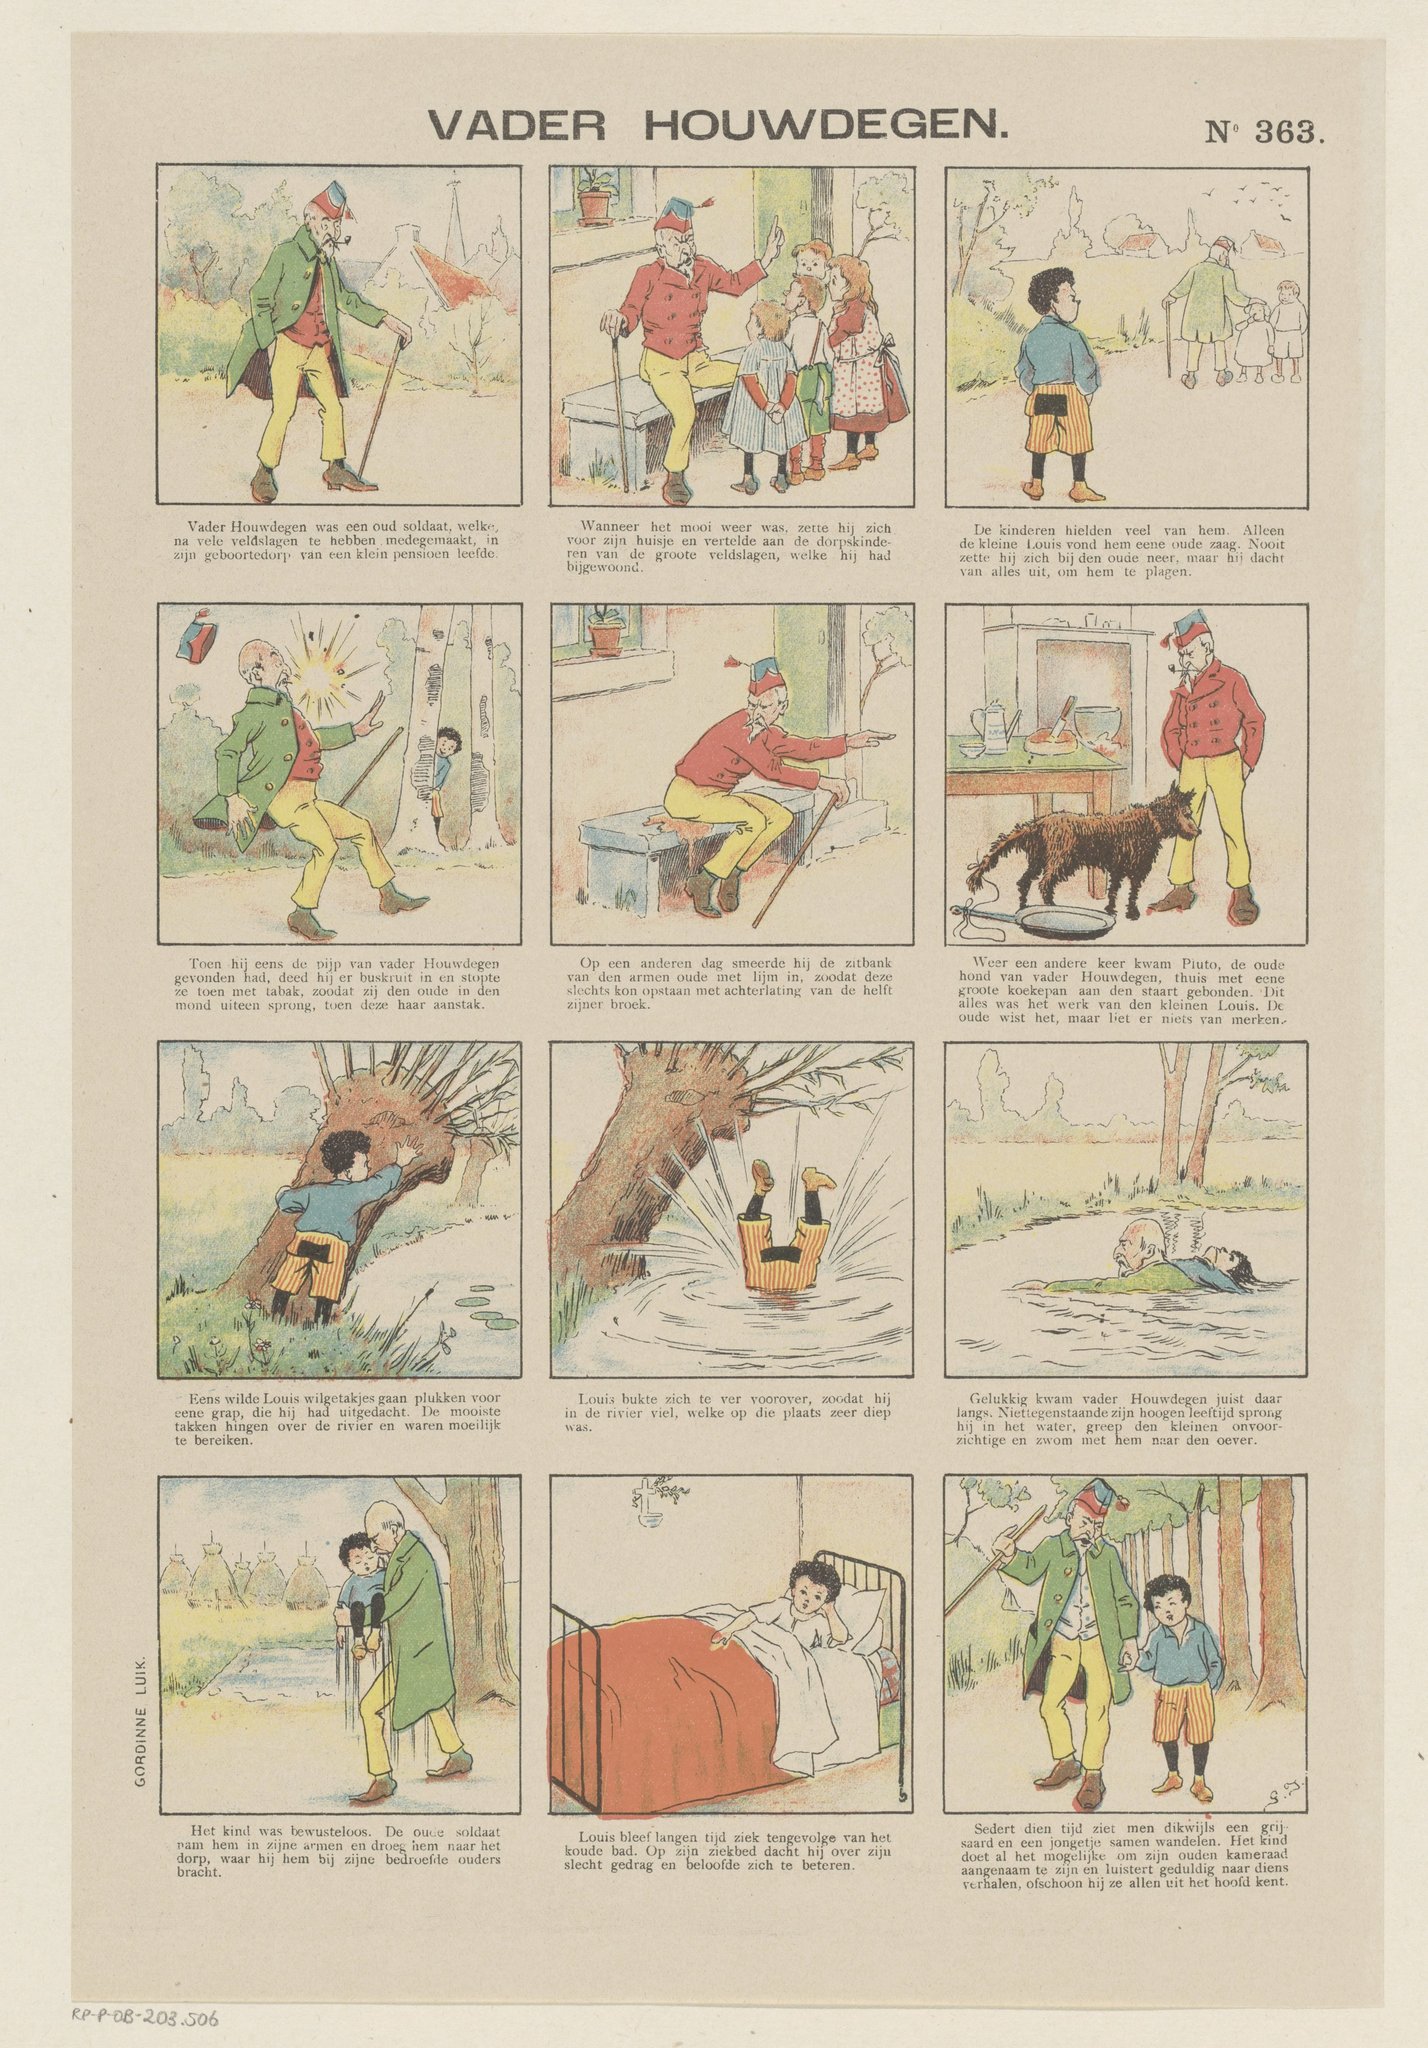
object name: print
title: Vader Houwdegen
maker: monogrammist g.j.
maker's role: print maker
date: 1894-1959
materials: paper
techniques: lithograph, letterpress printing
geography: liège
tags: mischief-making play, story teller; listening to story teller, veteran, bad behaviour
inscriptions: collector's mark: Lugt 2760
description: Blad met 12 voorstellingen over de oude veteraan Vader Houwdegen en de kwajongen Louis. Onder elke afbeelding een onderschrift. Genummerd rechtsboven: No 363.